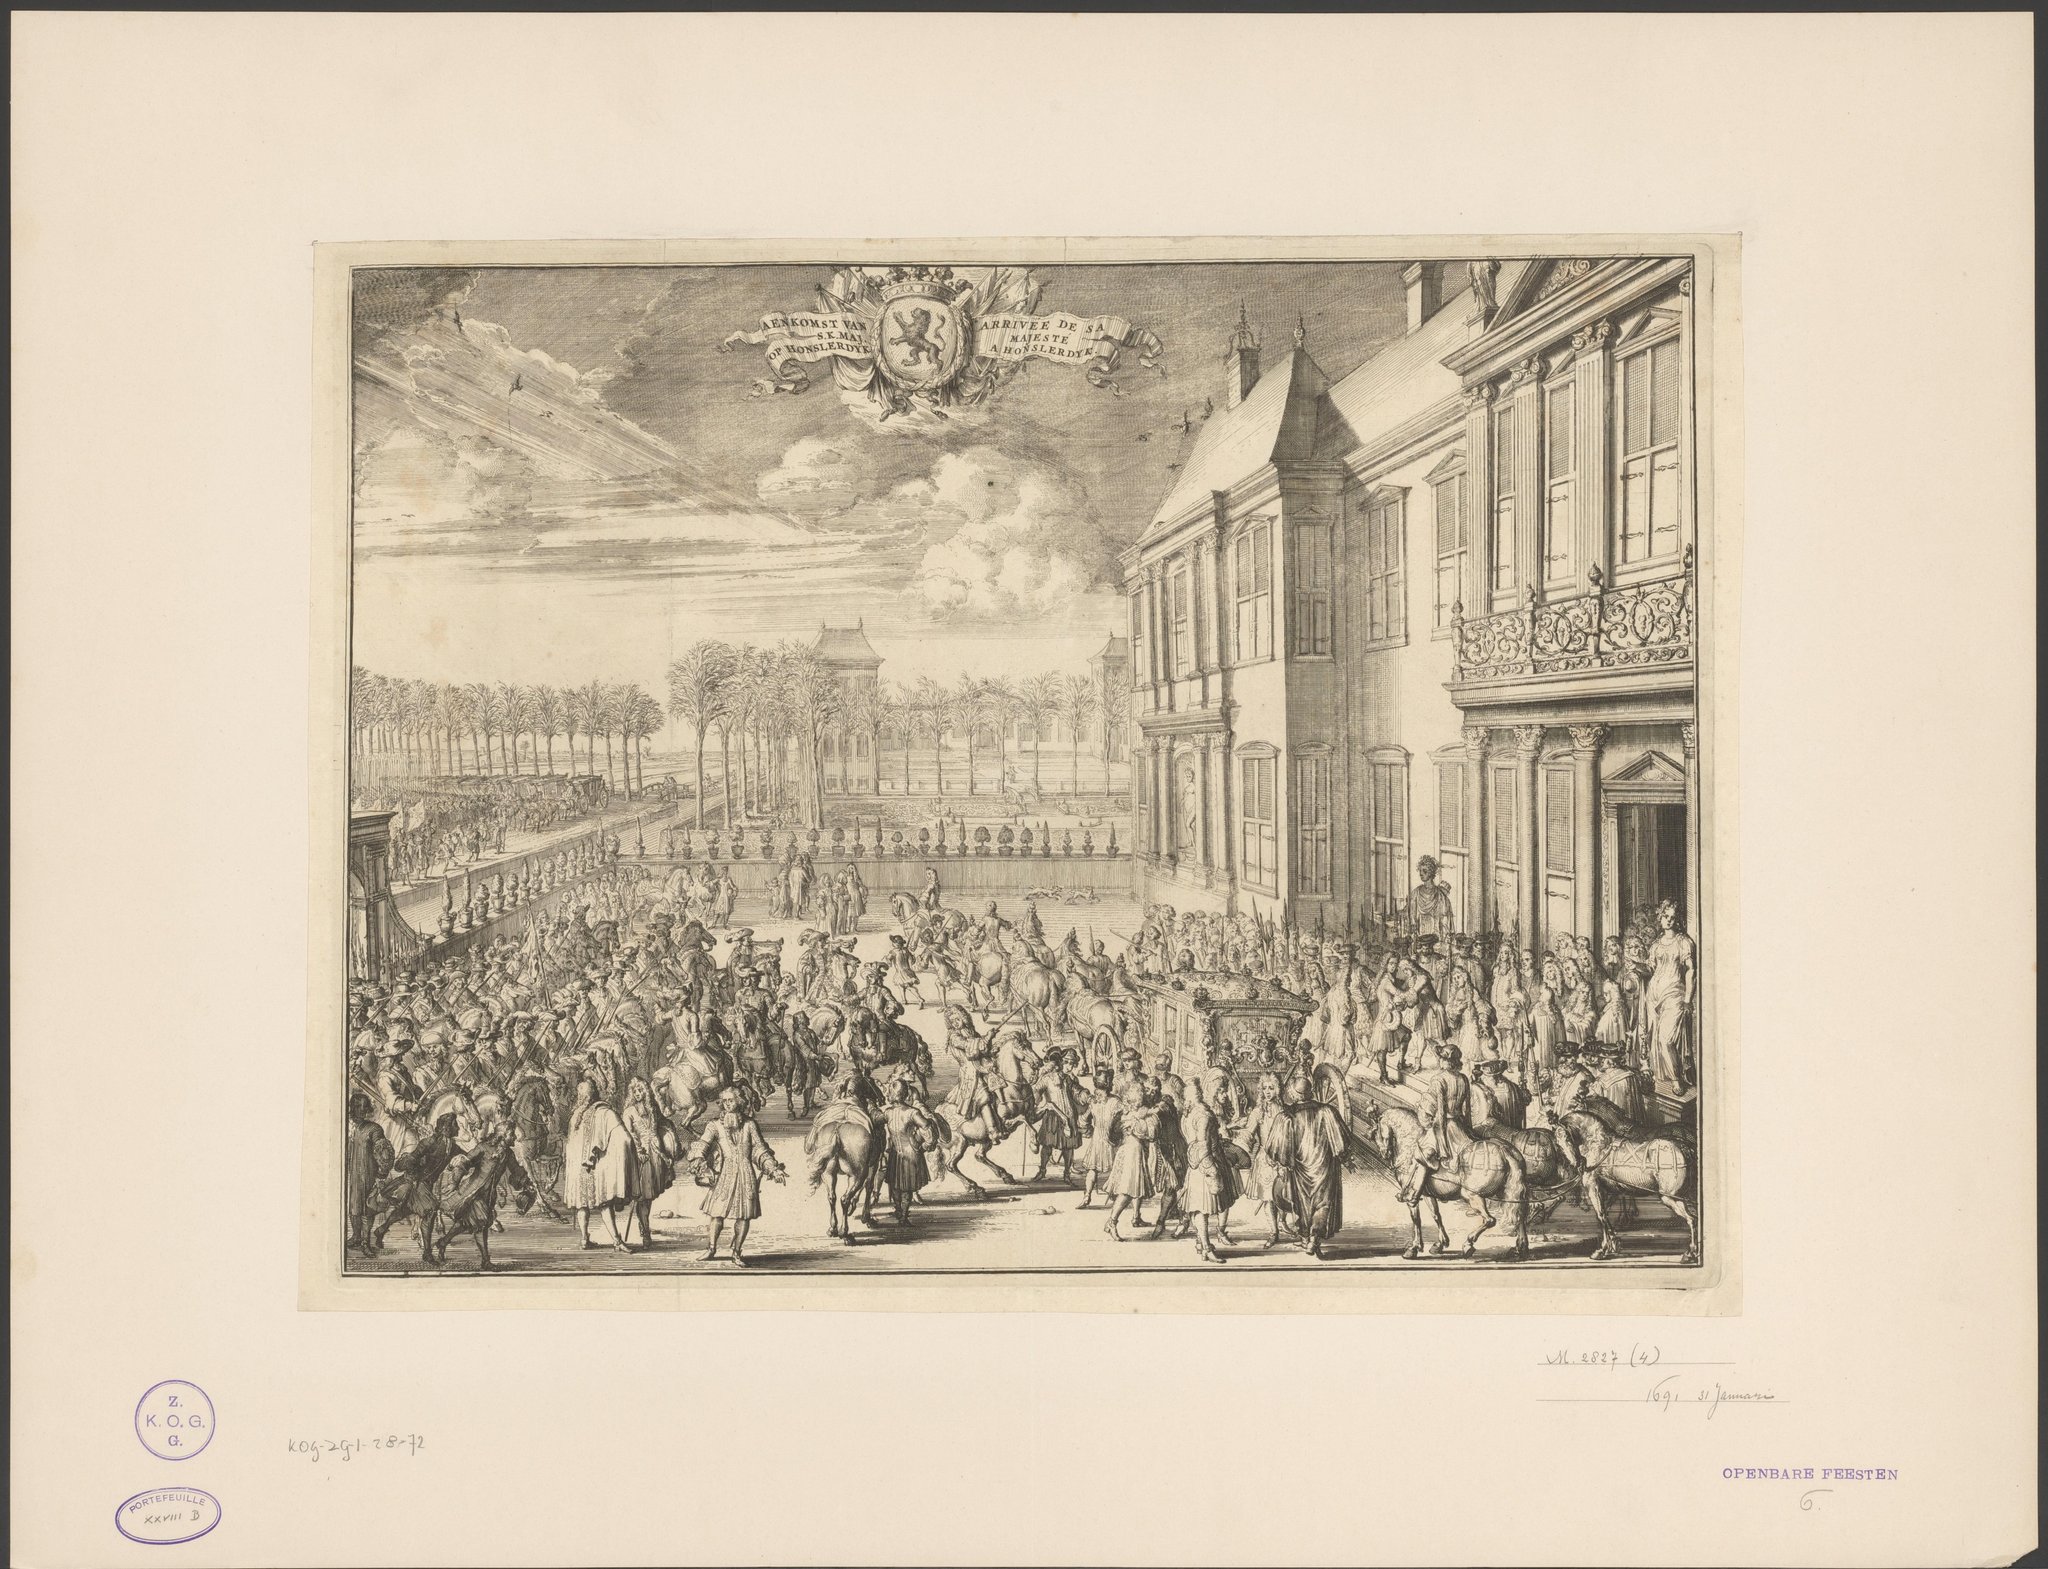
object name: print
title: Aenkomst van S.K. Maj. op Honslerdyk / Arrivée de sa majesté a Honslerdyk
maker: romeyn de hooghe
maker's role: draughtsman, goldsmith, painter, print maker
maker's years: 1645-1708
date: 1691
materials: paper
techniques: etching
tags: the hague, william iii (prince of orange and king of england, scotland, and ireland), prince, palace, arrival and return ~ travelling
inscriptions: collector's mark: Lugt 1641, stamp, stamp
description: Aankomst van stadhouder-koning Willem III op Paleis Honselaarsdijk, februari 1691. Soldaten en rijtuigen voor het paleis. De koning wordt verwelkomt op het paleis. Onderwerpsrubrieken binnen de Atlas Zeden en Gewoonten: Zeden en Gewoonten in Engeren Zin. Volksleven. Openbare feesten. Vorstelijke intochten, (Illuminaties, vuurwerken en dergelijke, openbare feesten).